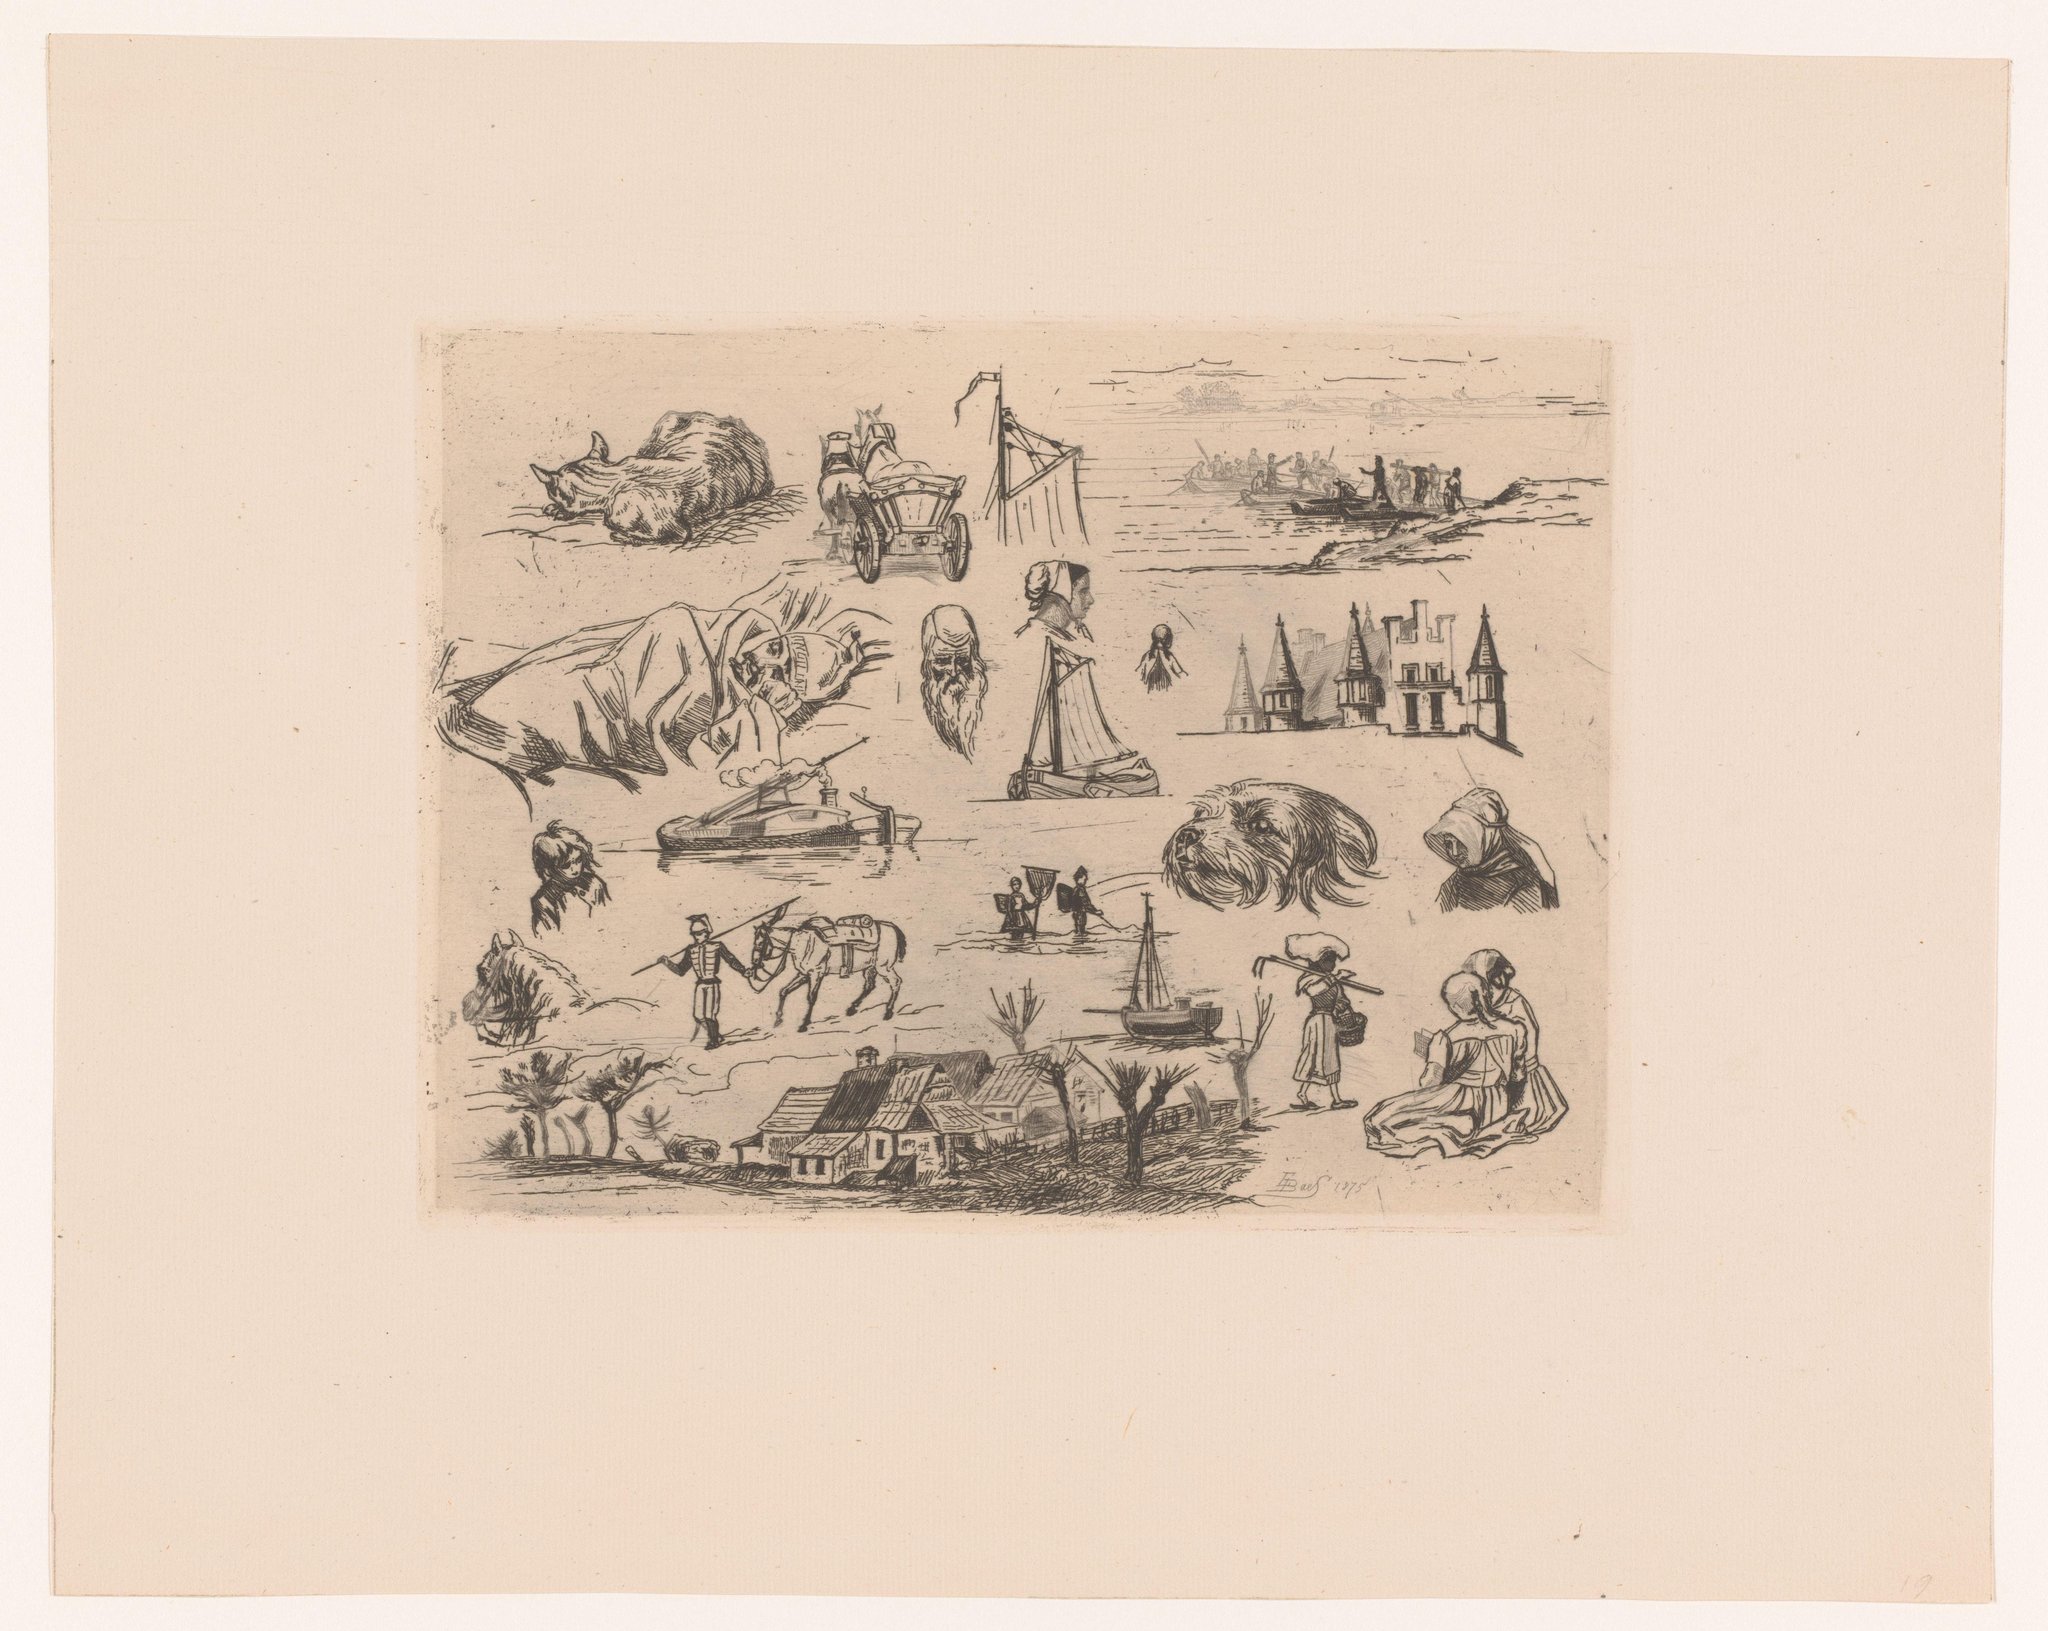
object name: print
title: Verschillende studies van figuren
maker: edgar alfred baes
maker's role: print maker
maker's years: 1837-1909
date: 1875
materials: paper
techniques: drypoint, etching, intaglio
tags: sailing-ship, sailing-boat, cat, sea and coastal fishery, dog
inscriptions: collector's mark: Lugt 2228